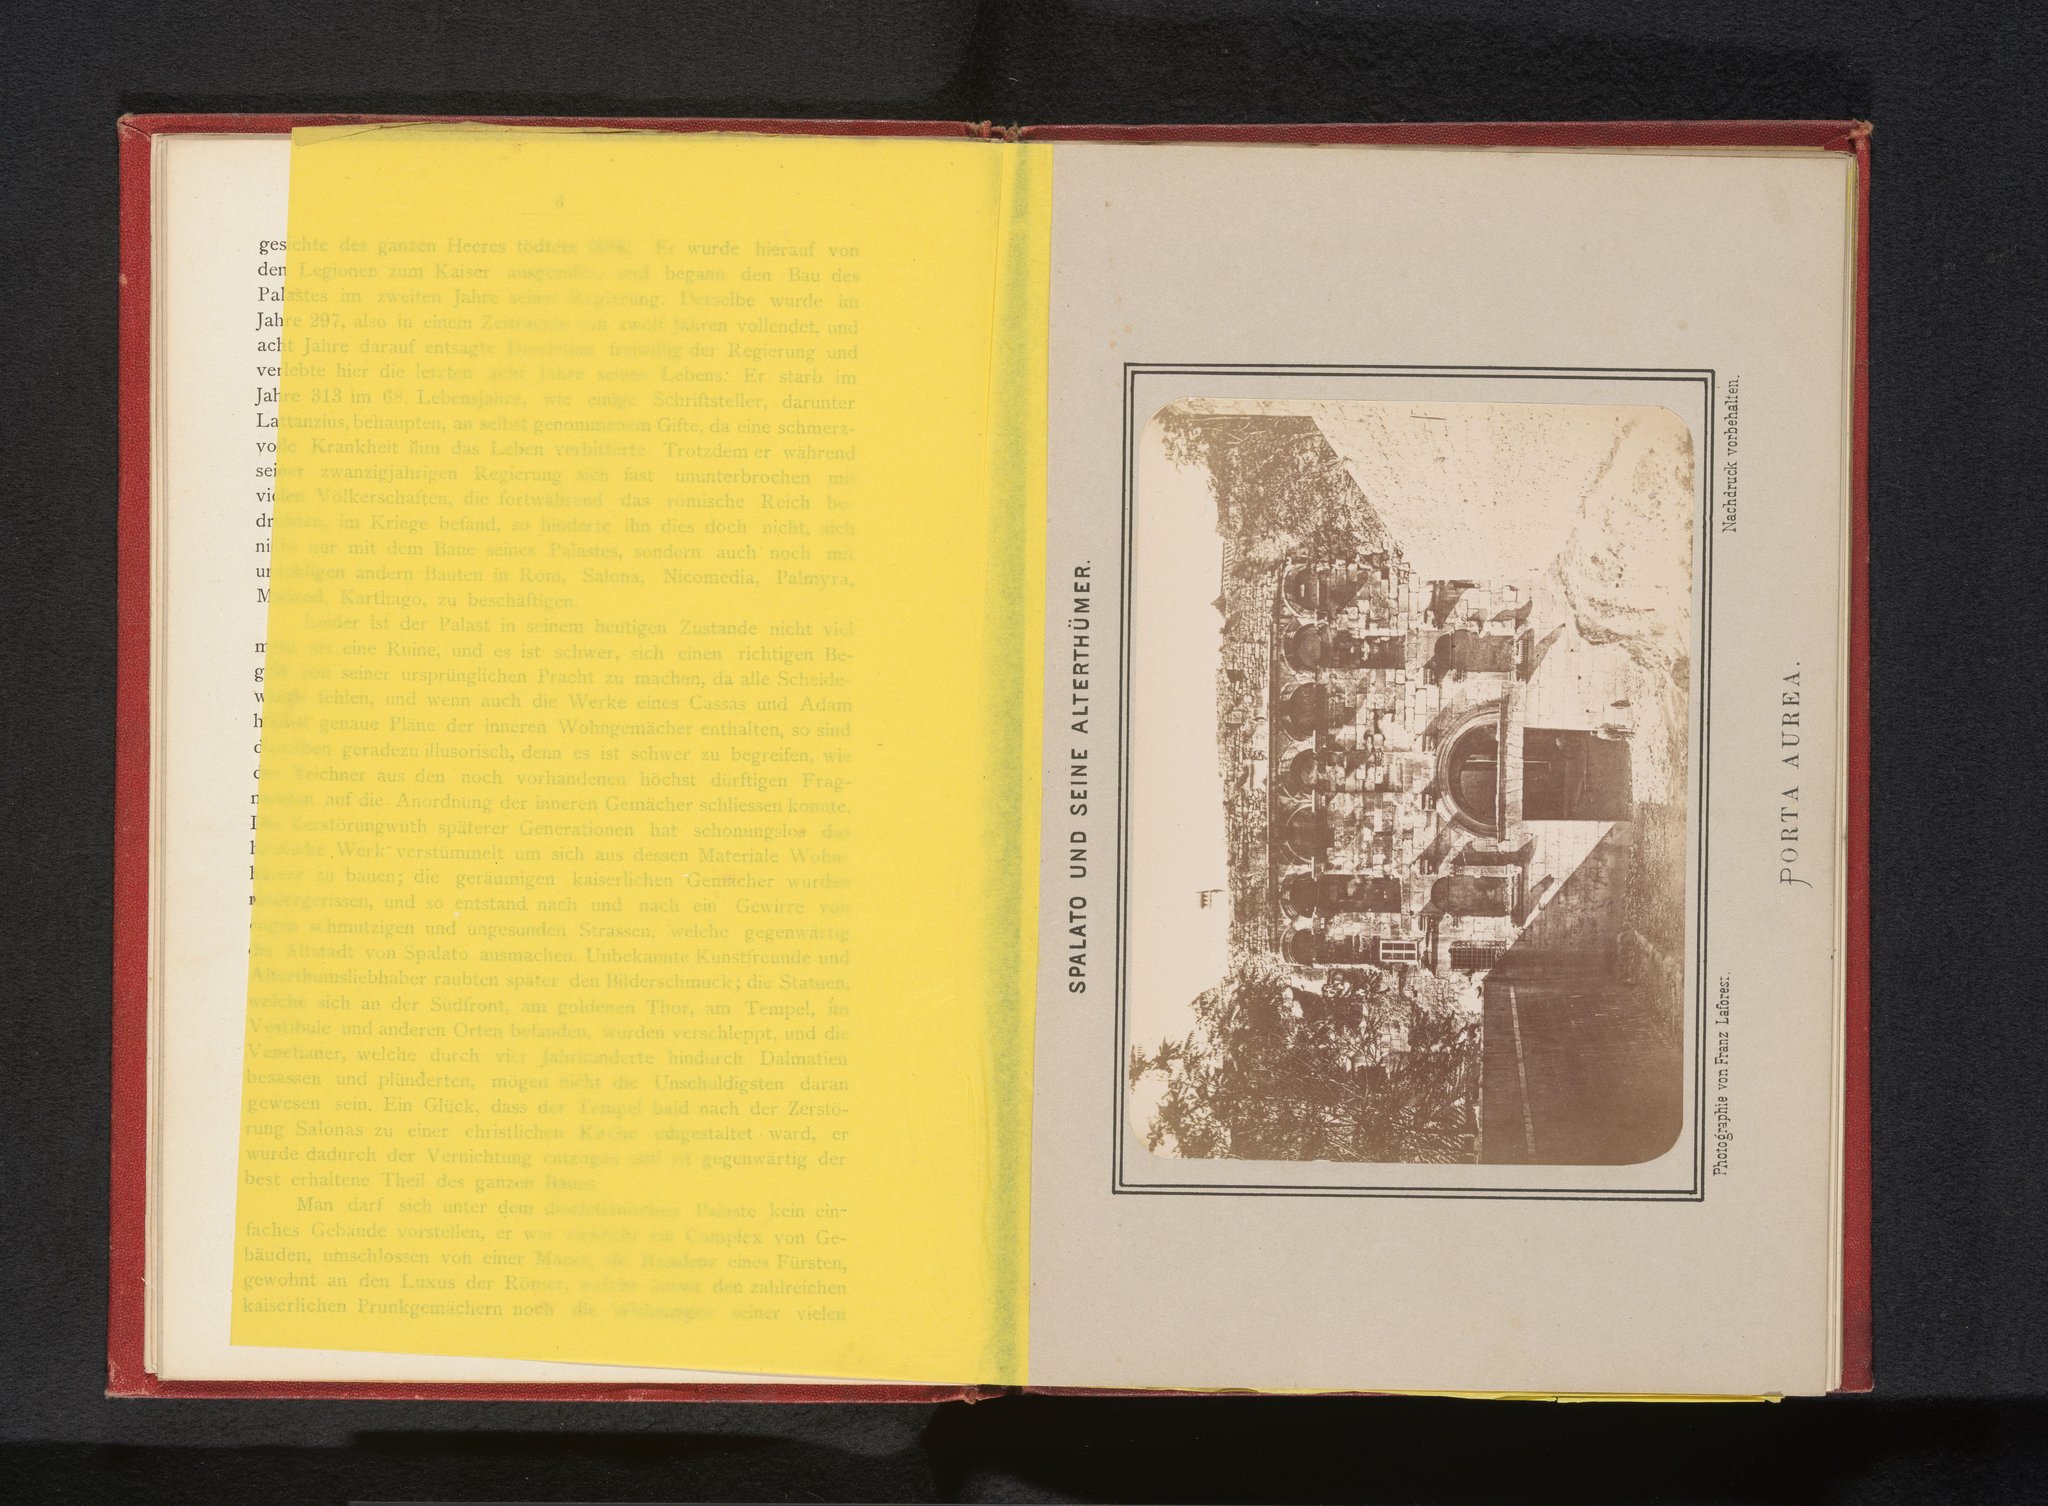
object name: photograph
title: Spalato und seine Alterthümer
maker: franz thiard de laforest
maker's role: fotograaf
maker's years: 1838-1911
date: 1868-1878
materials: photographic support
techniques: albumen print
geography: split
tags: city-gate